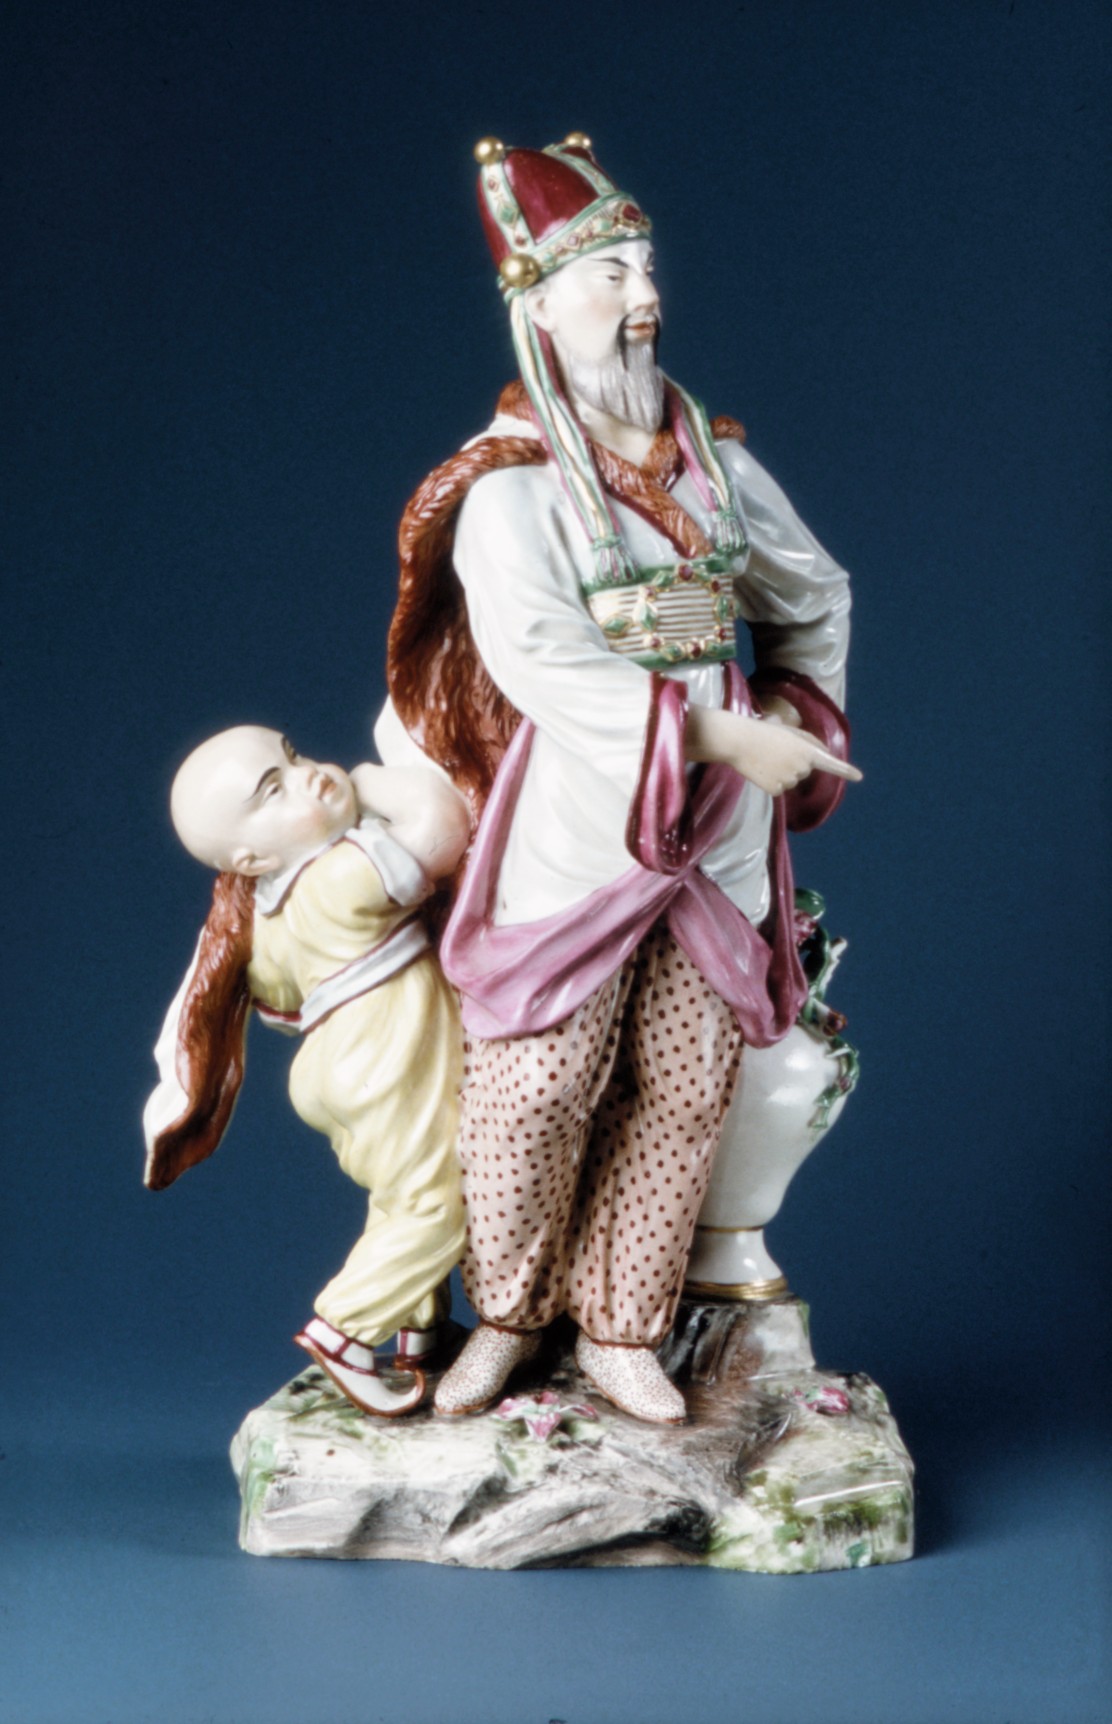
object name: group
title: Chinese emperor and attendant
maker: ludwigsburg porcelain manufactory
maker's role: manufactory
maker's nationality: german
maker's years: 1758-1824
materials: hard paste porcelain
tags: kings,boys